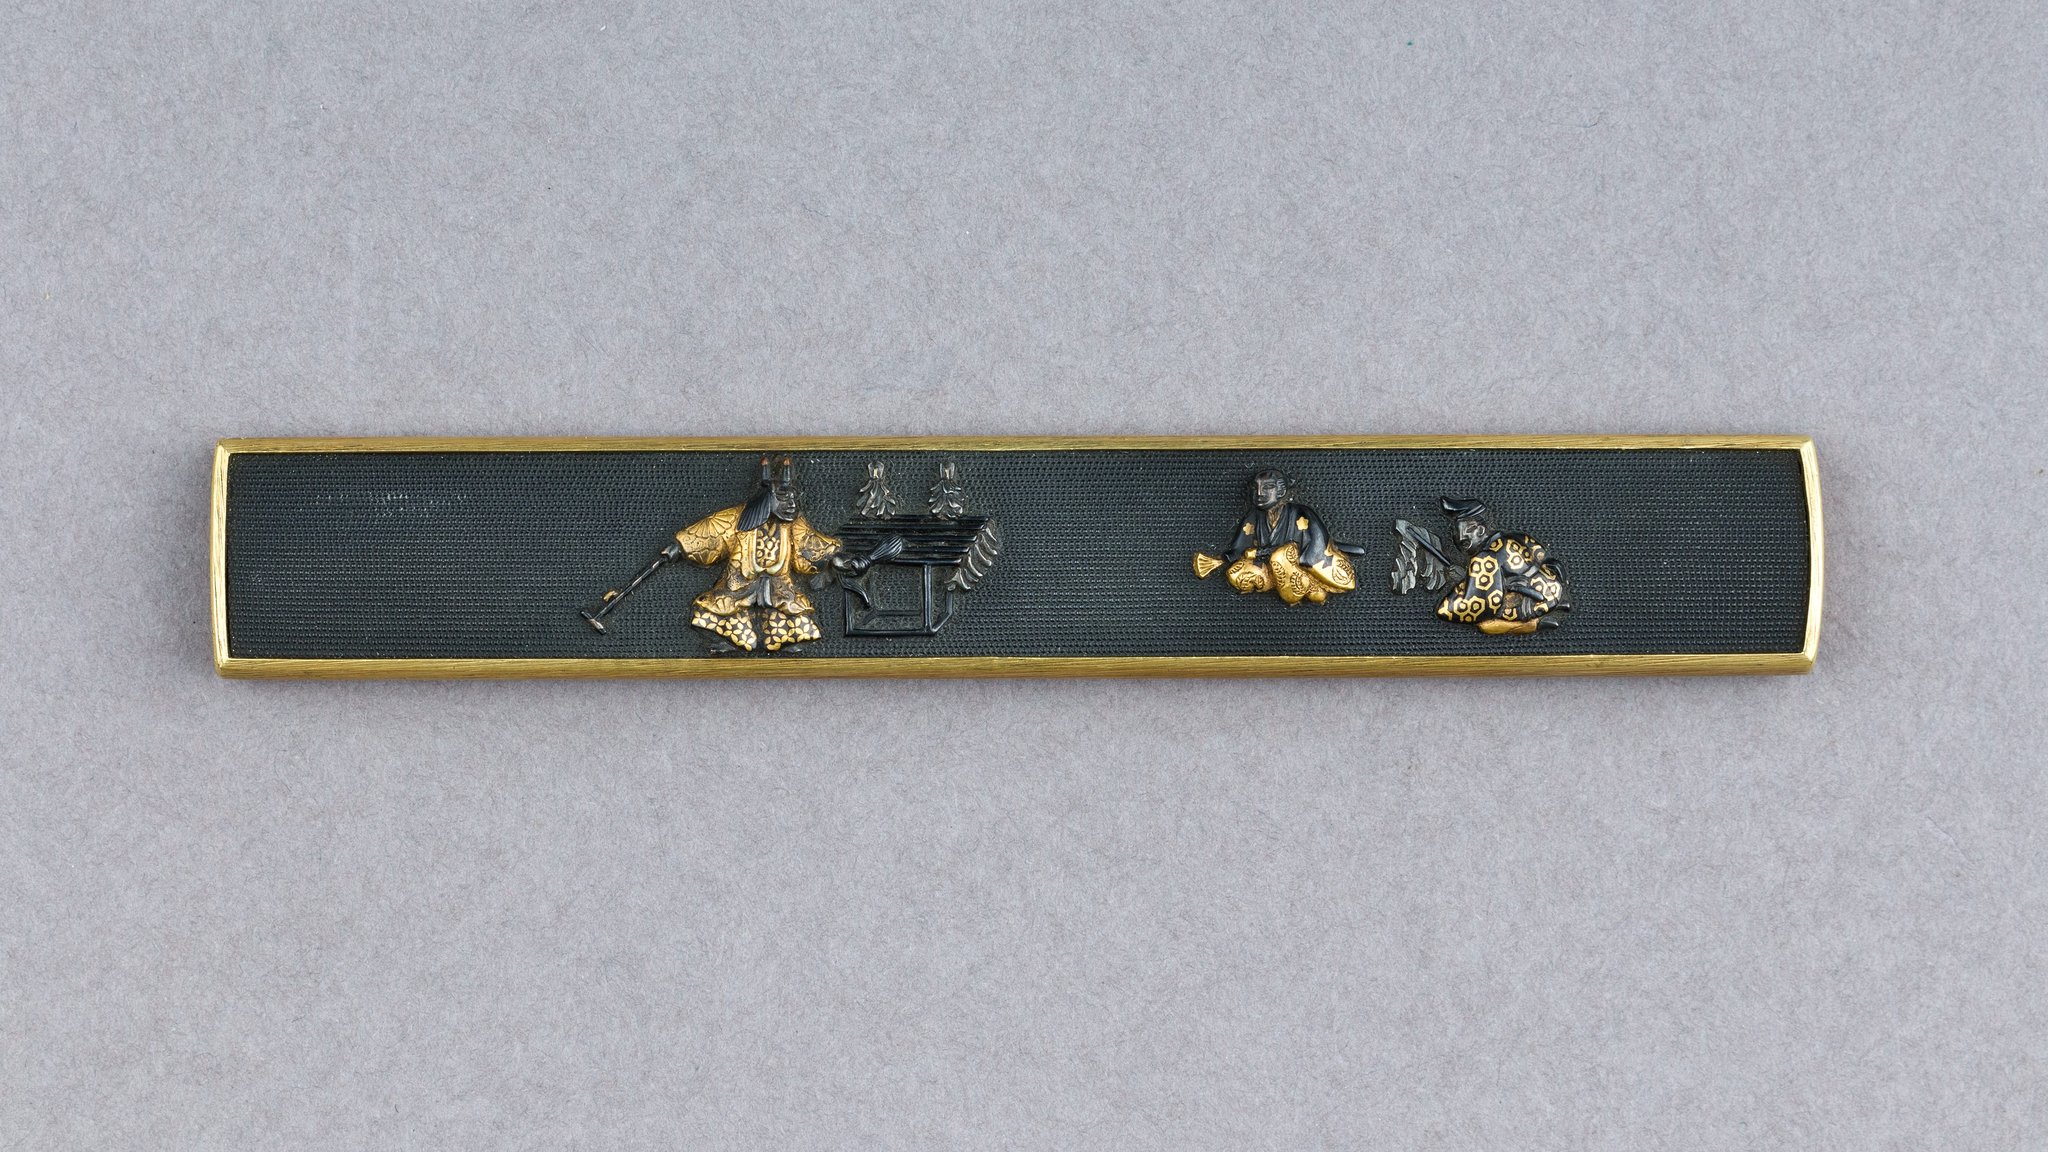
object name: knife handle kozuka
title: Knife Handle (Kozuka)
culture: japanese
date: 1615-1868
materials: copper, gold alloy, gold, silver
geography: japan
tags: men